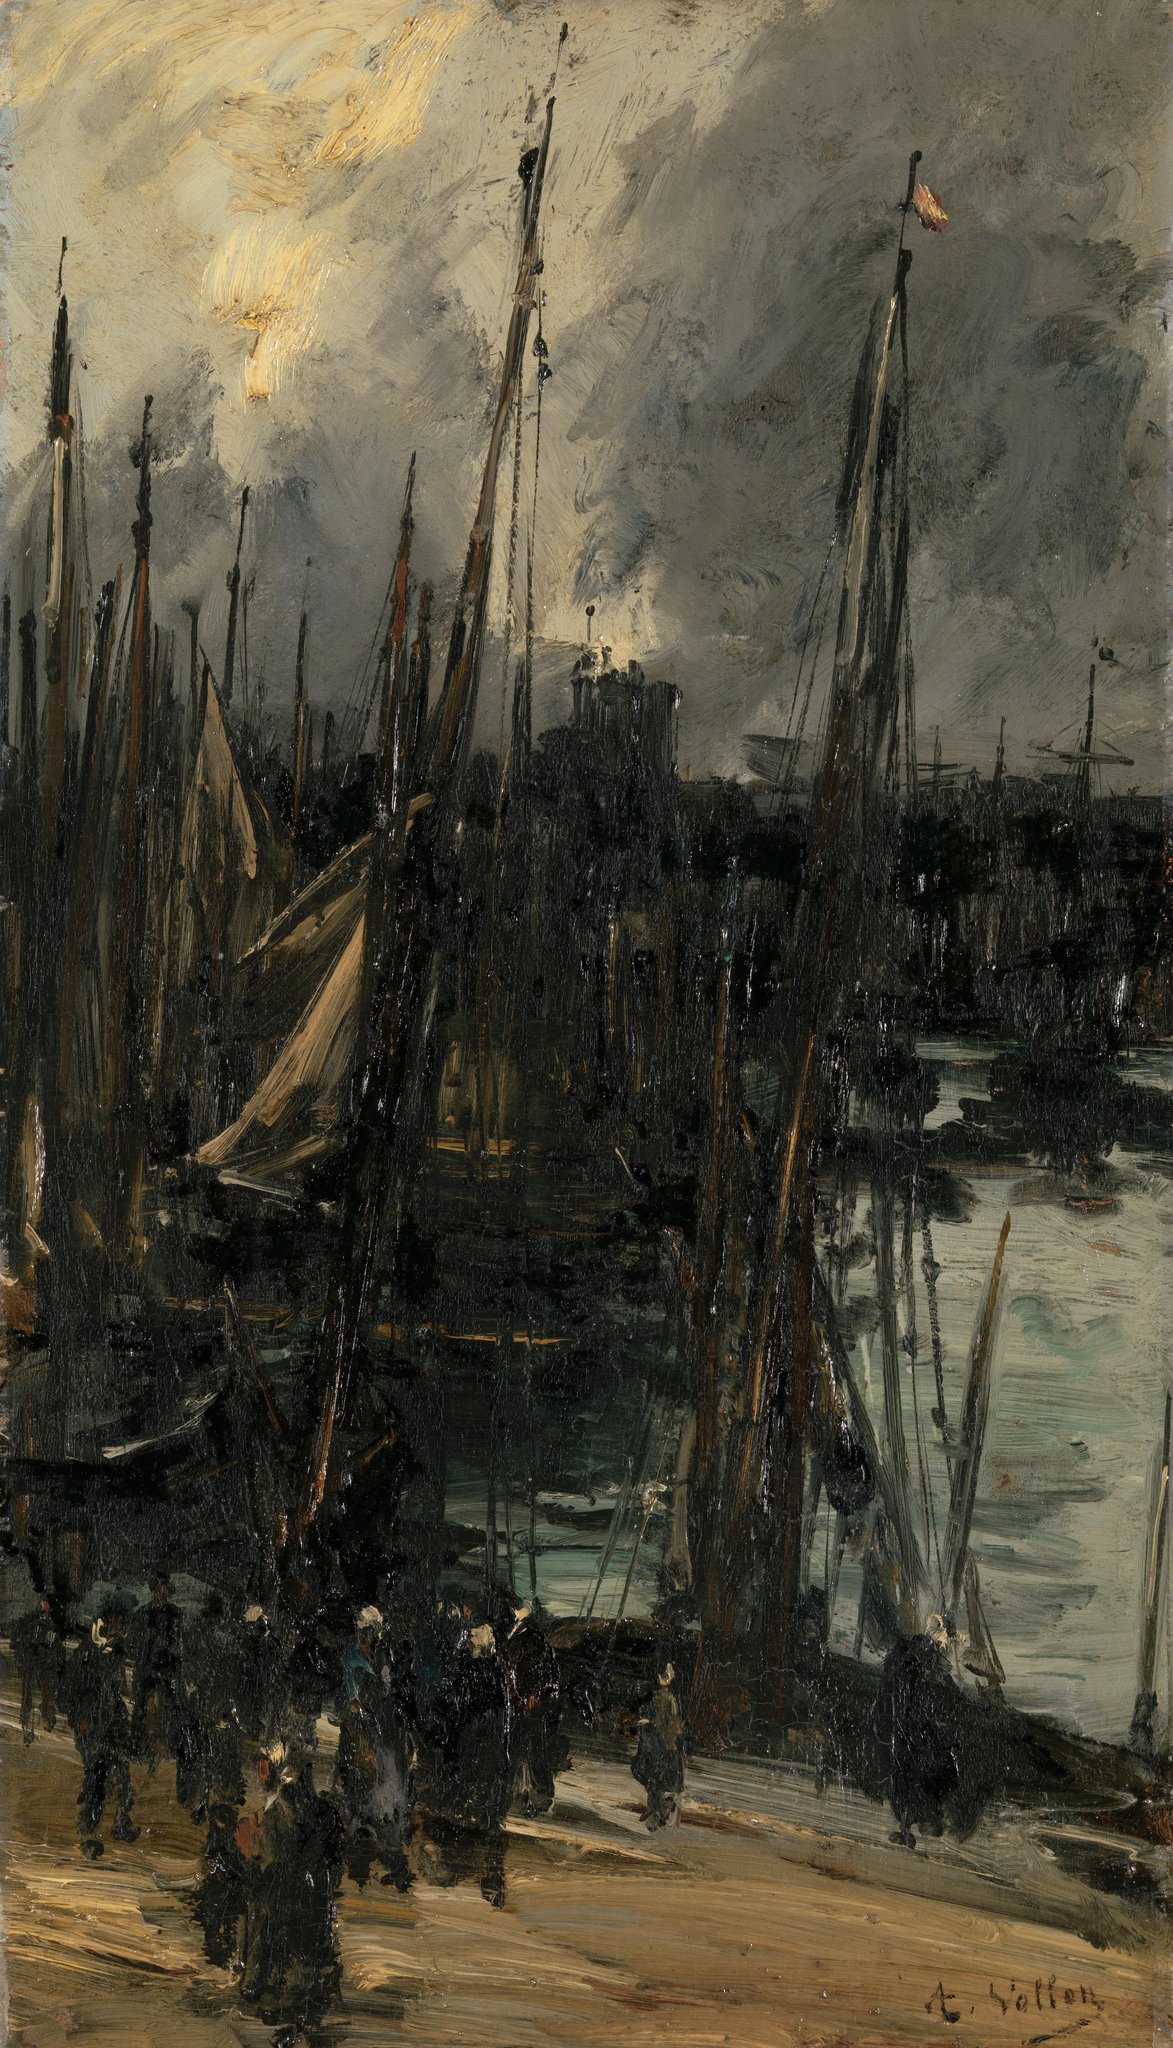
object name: painting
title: Harbour view in Dunkerque (or Dieppe?)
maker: antoine vollon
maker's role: painter, print maker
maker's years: 1833-1900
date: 1880-1900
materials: oil, panel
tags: harbour, sailing-ship, sailing-boat, sea and coastal fishery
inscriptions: signature: ‘A. Vollon’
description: Havengezicht in Duinkerken. Gezicht op de masten van de vissersschepen liggend in de haven van Duinkerken (of Dieppe?). Op de voorgrond een groep vissers.